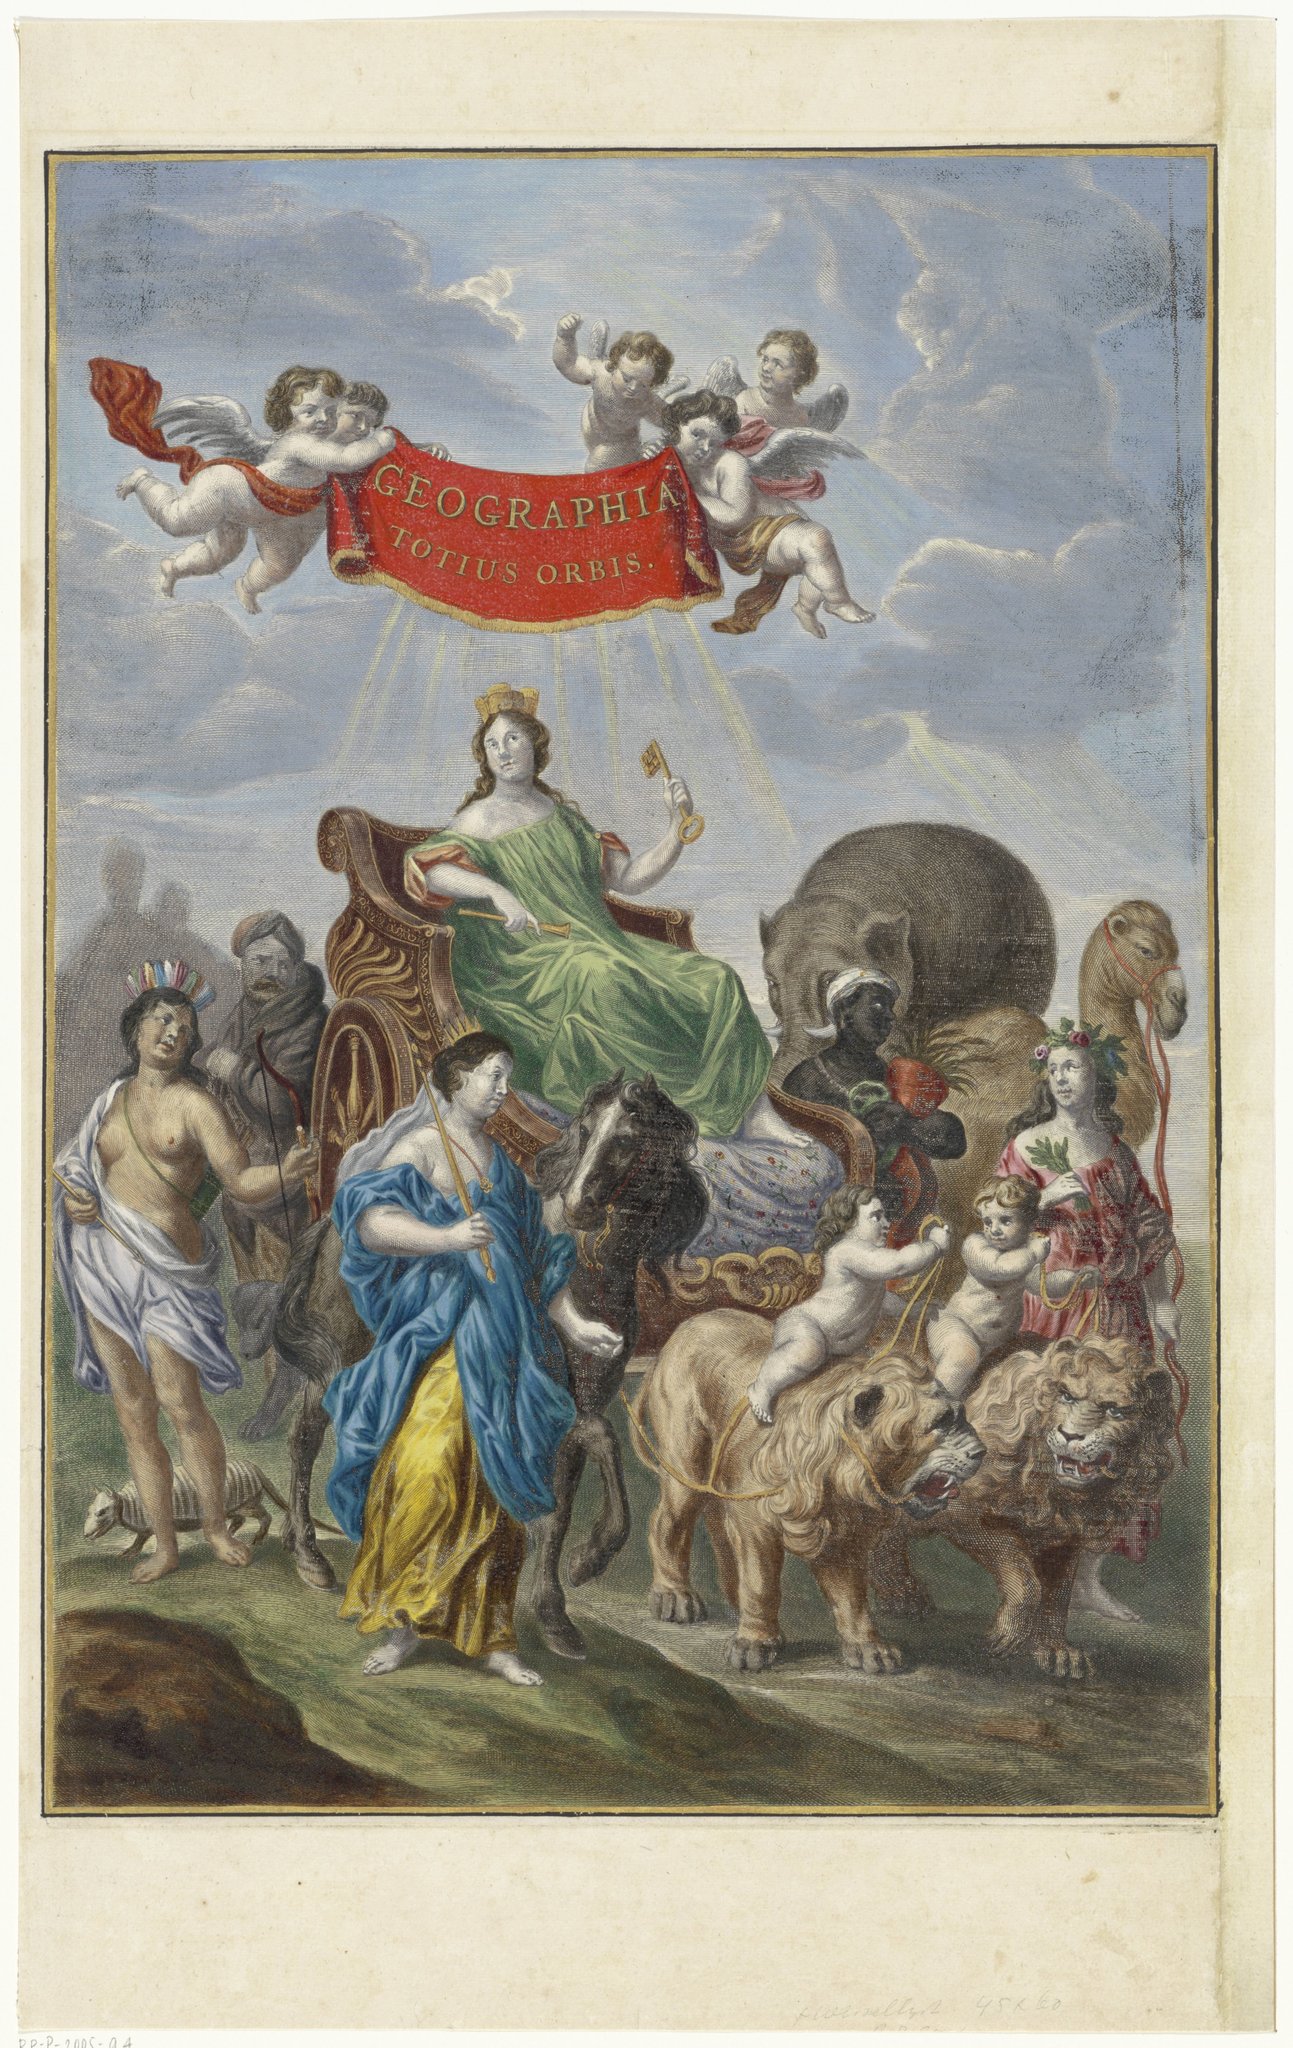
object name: print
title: Geographia totius orbis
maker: Anonymous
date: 1650-1790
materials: paper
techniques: engraving, hand coloring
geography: netherlands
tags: europe represented allegorically; 'europa' (ripa), asia represented allegorically; 'asia' (ripa), africa represented allegorically; 'africa' (ripa), america represented allegorically; 'america' (ripa), native peoples of the americas, continents represented allegorically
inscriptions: collector's mark: Lugt 2760, collector's mark: Lugt 2228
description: Op een triomfwagen zit de personificatie van de Geographia totius orbis met een stedenkroon op haar hoofd, een sleutel in haar linkerhand en een scepter in haar rechterhand. Links loopt de personificatie van het werelddeel Amerika met een verentooi. Voor Amerika voert Europa met een kroon en een scepter een paard aan de hand mee. Rechts loopt de personificatie van Afrika in de gedaante van een zwarte vrouw naast een olifant. Voor haar is Azië weergegeven als een vrouw met bloemen in het haar, die een kameel meevoert. De kar wordt getrokken door twee leeuwen met twee putti. In de lucht vijf putti met de titel op een banderol.